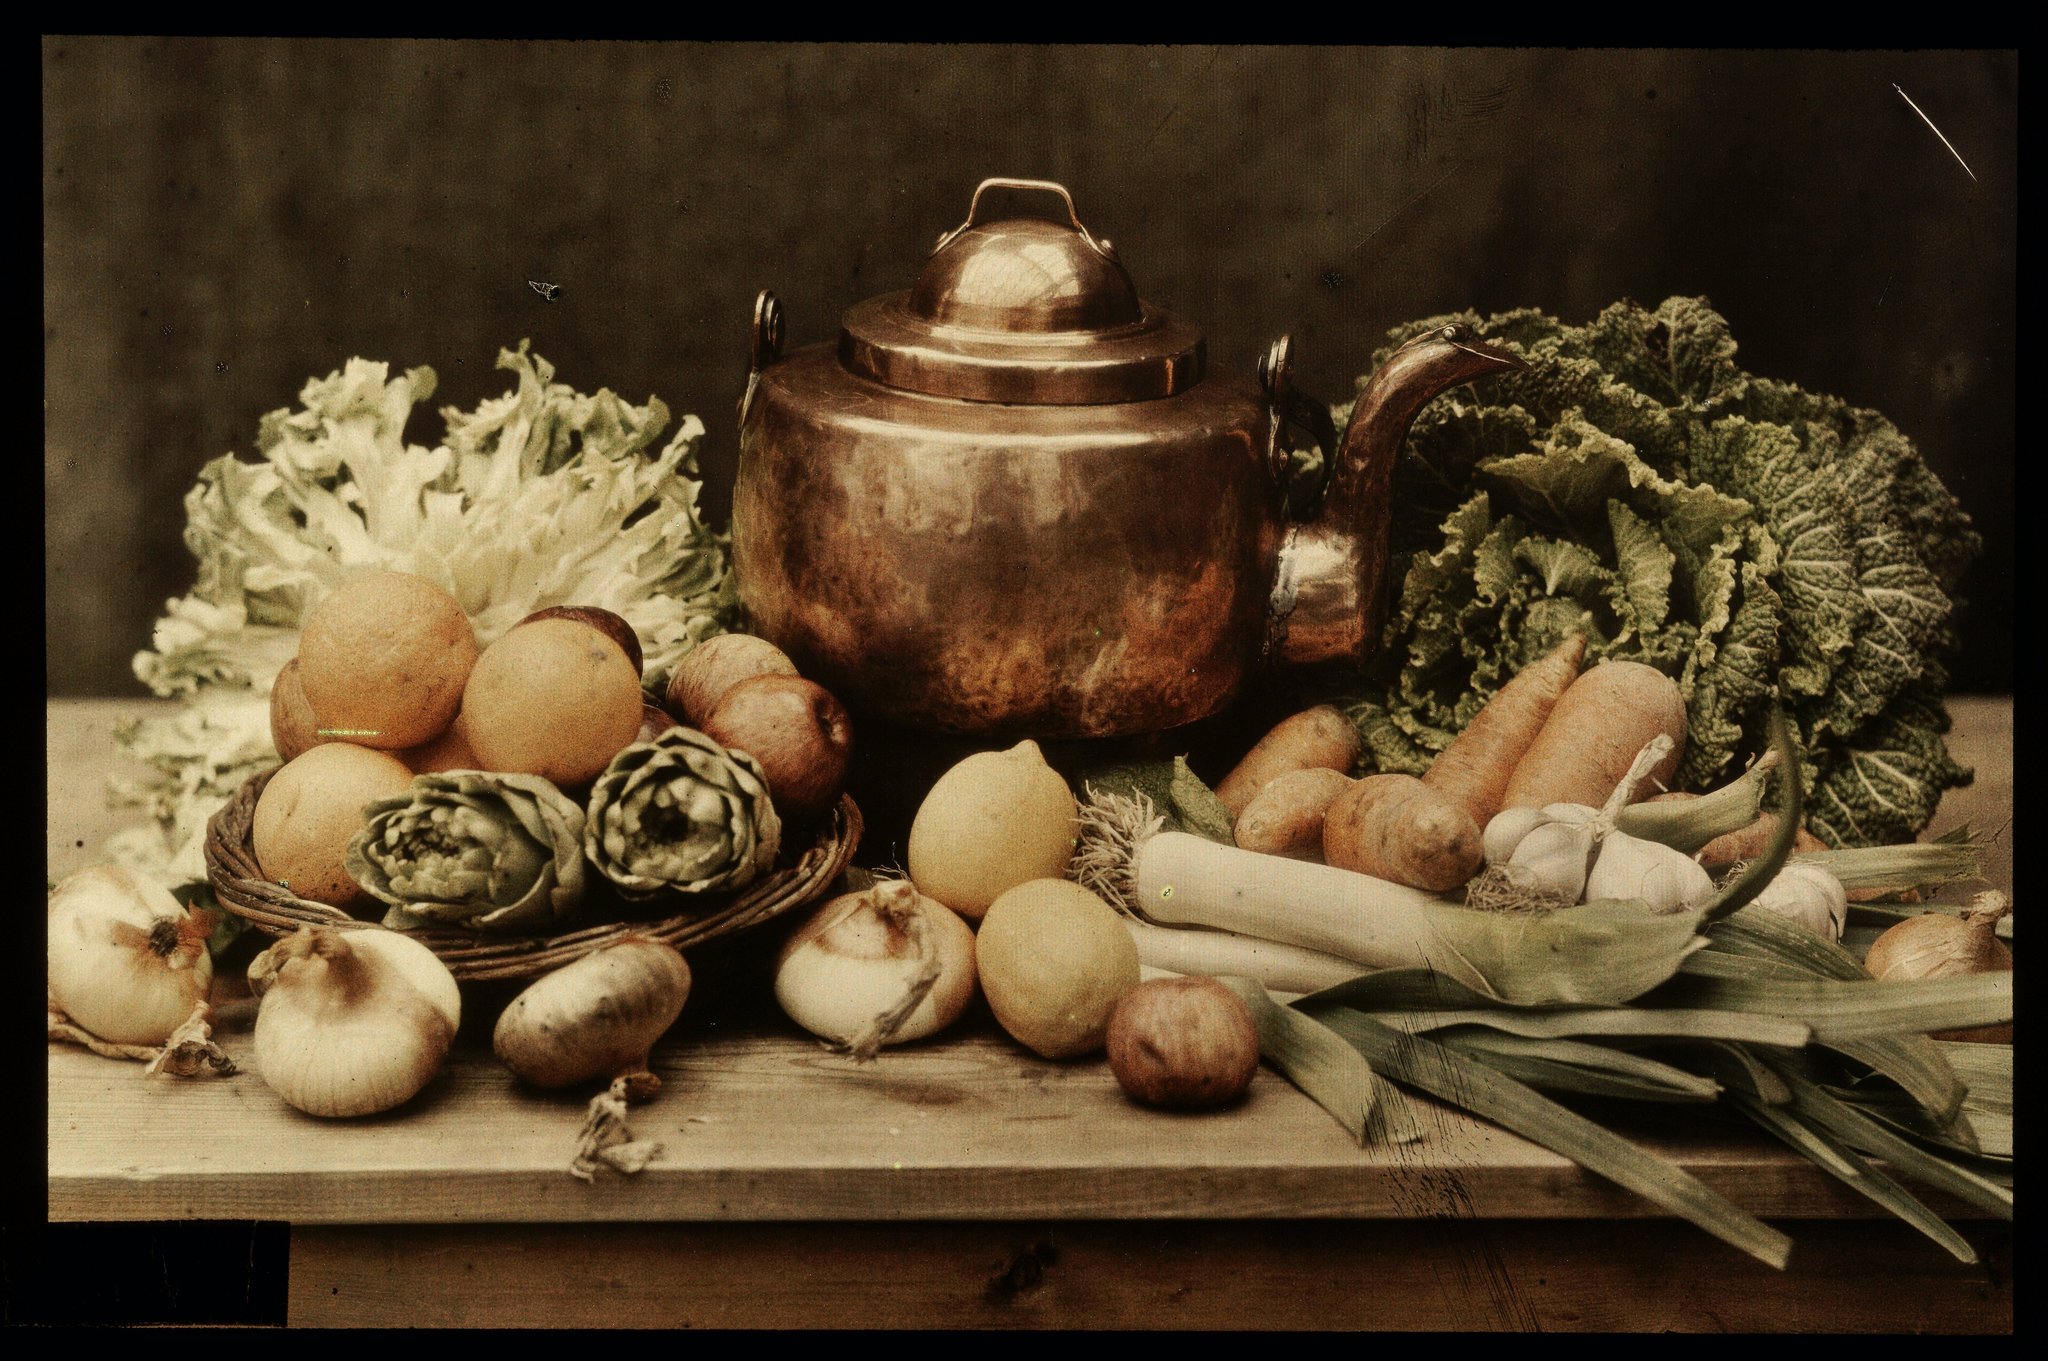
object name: color slide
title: Stilleven met fruit, groenten en een koperen ketel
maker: Anonymous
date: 1907-1930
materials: glass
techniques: autochrome process, slide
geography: france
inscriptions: label: ‘AUTOCHROMES / LUMIERE’